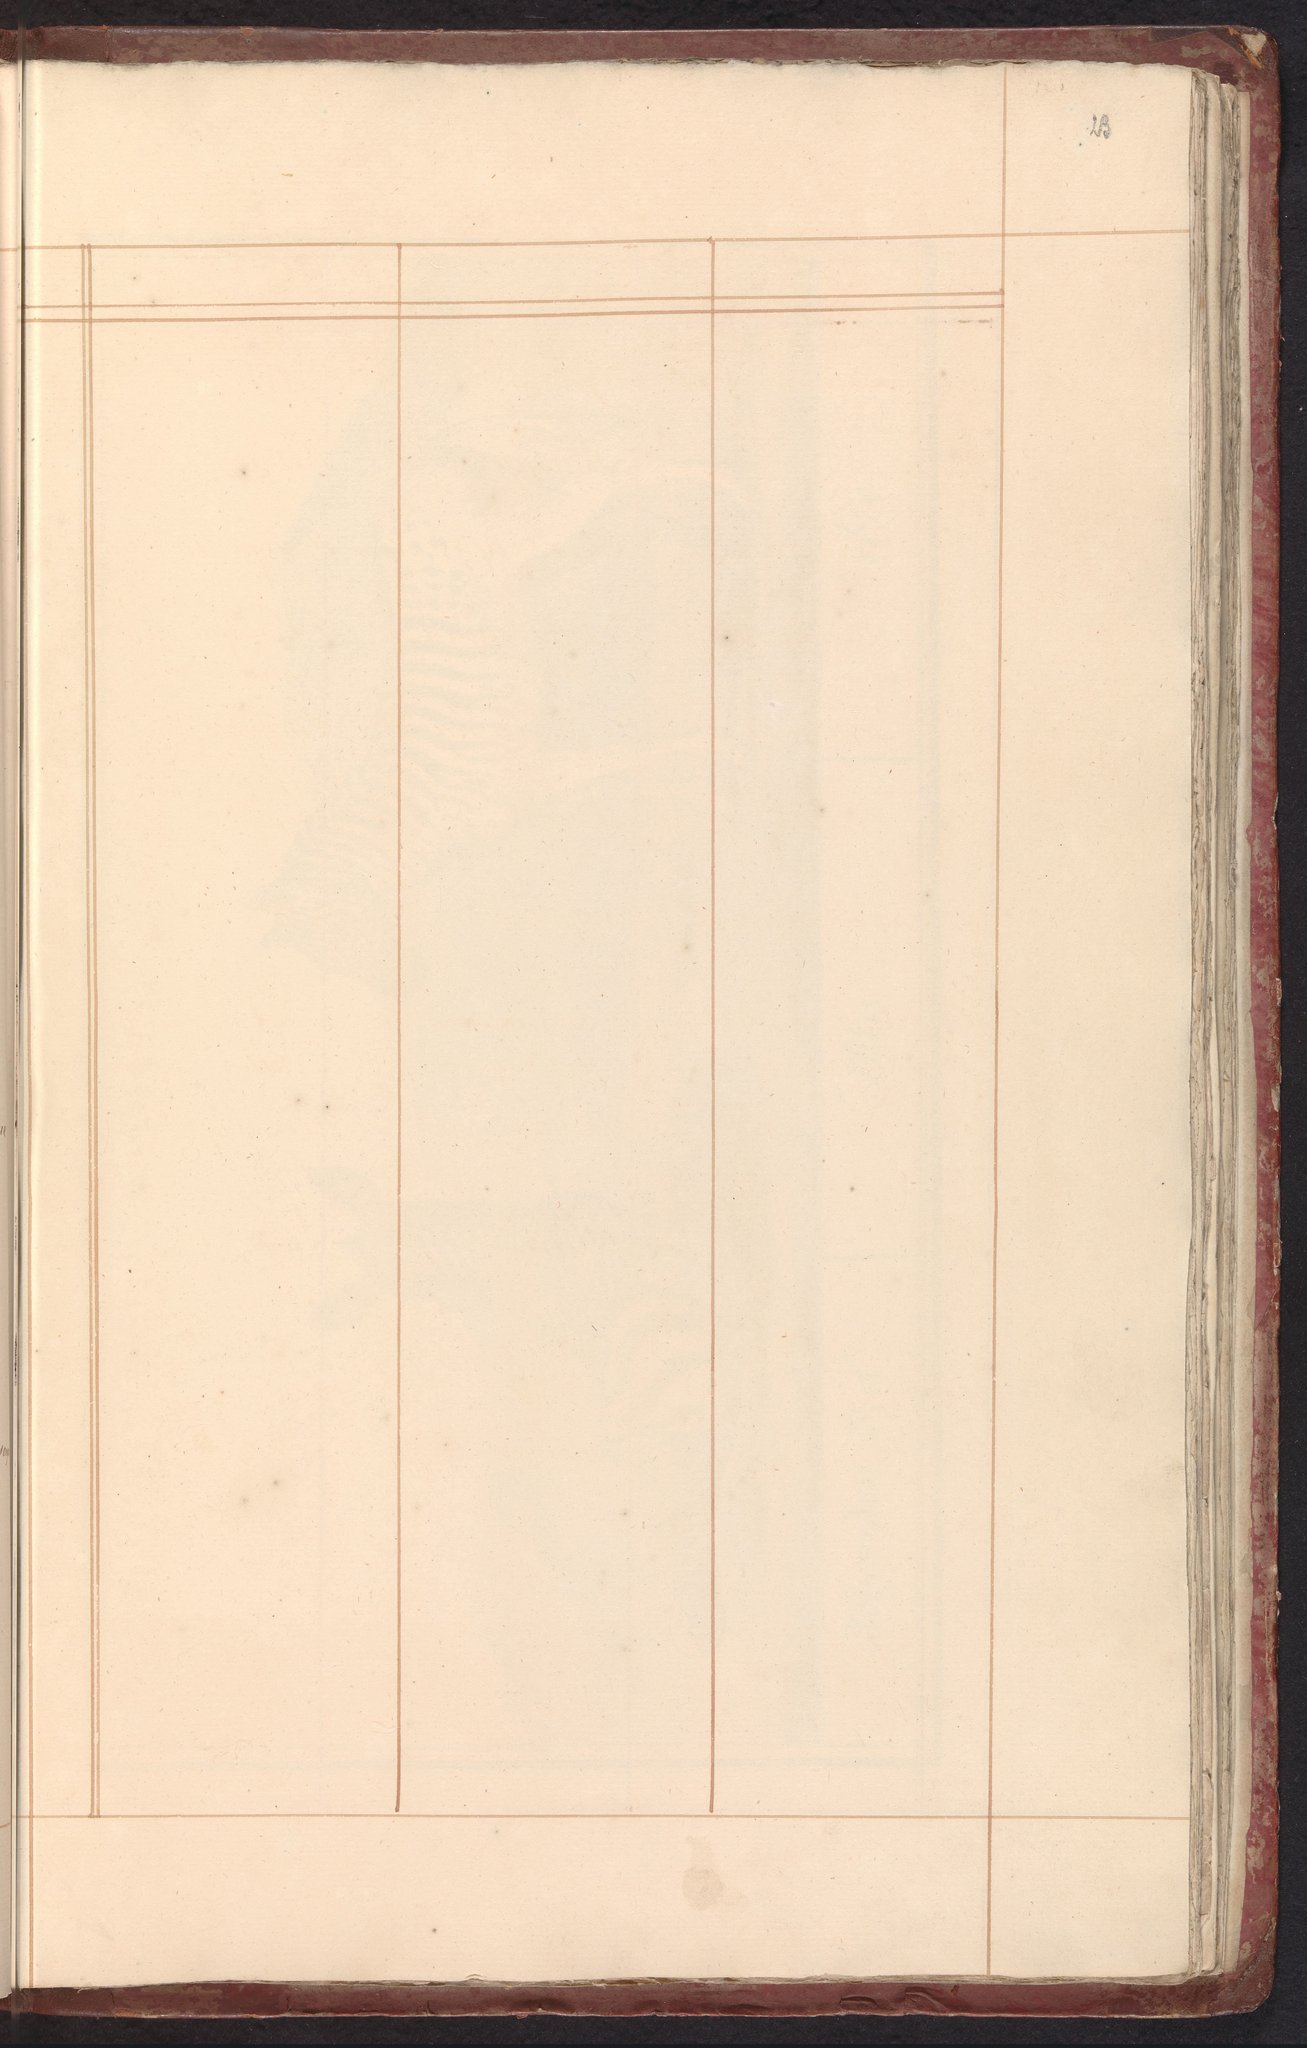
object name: manuscript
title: Oningevuld schema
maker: joseph van huerne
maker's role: kunstliefhebber, mecenas, verzamelaar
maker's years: 1752-1844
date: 1809-1814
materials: ink, paper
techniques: pen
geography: bruges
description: Oningevuld schema met drie kolommen. Onderdeel van het tweede album met tekeningen van viervoeters. Tweede van twaalf albums met tekeningen van dieren, vogels en planten bekend rond 1600, gemaakt in opdracht van keizer Rudolf II. Met toelichting in Nederlands, Latijn en Frans.